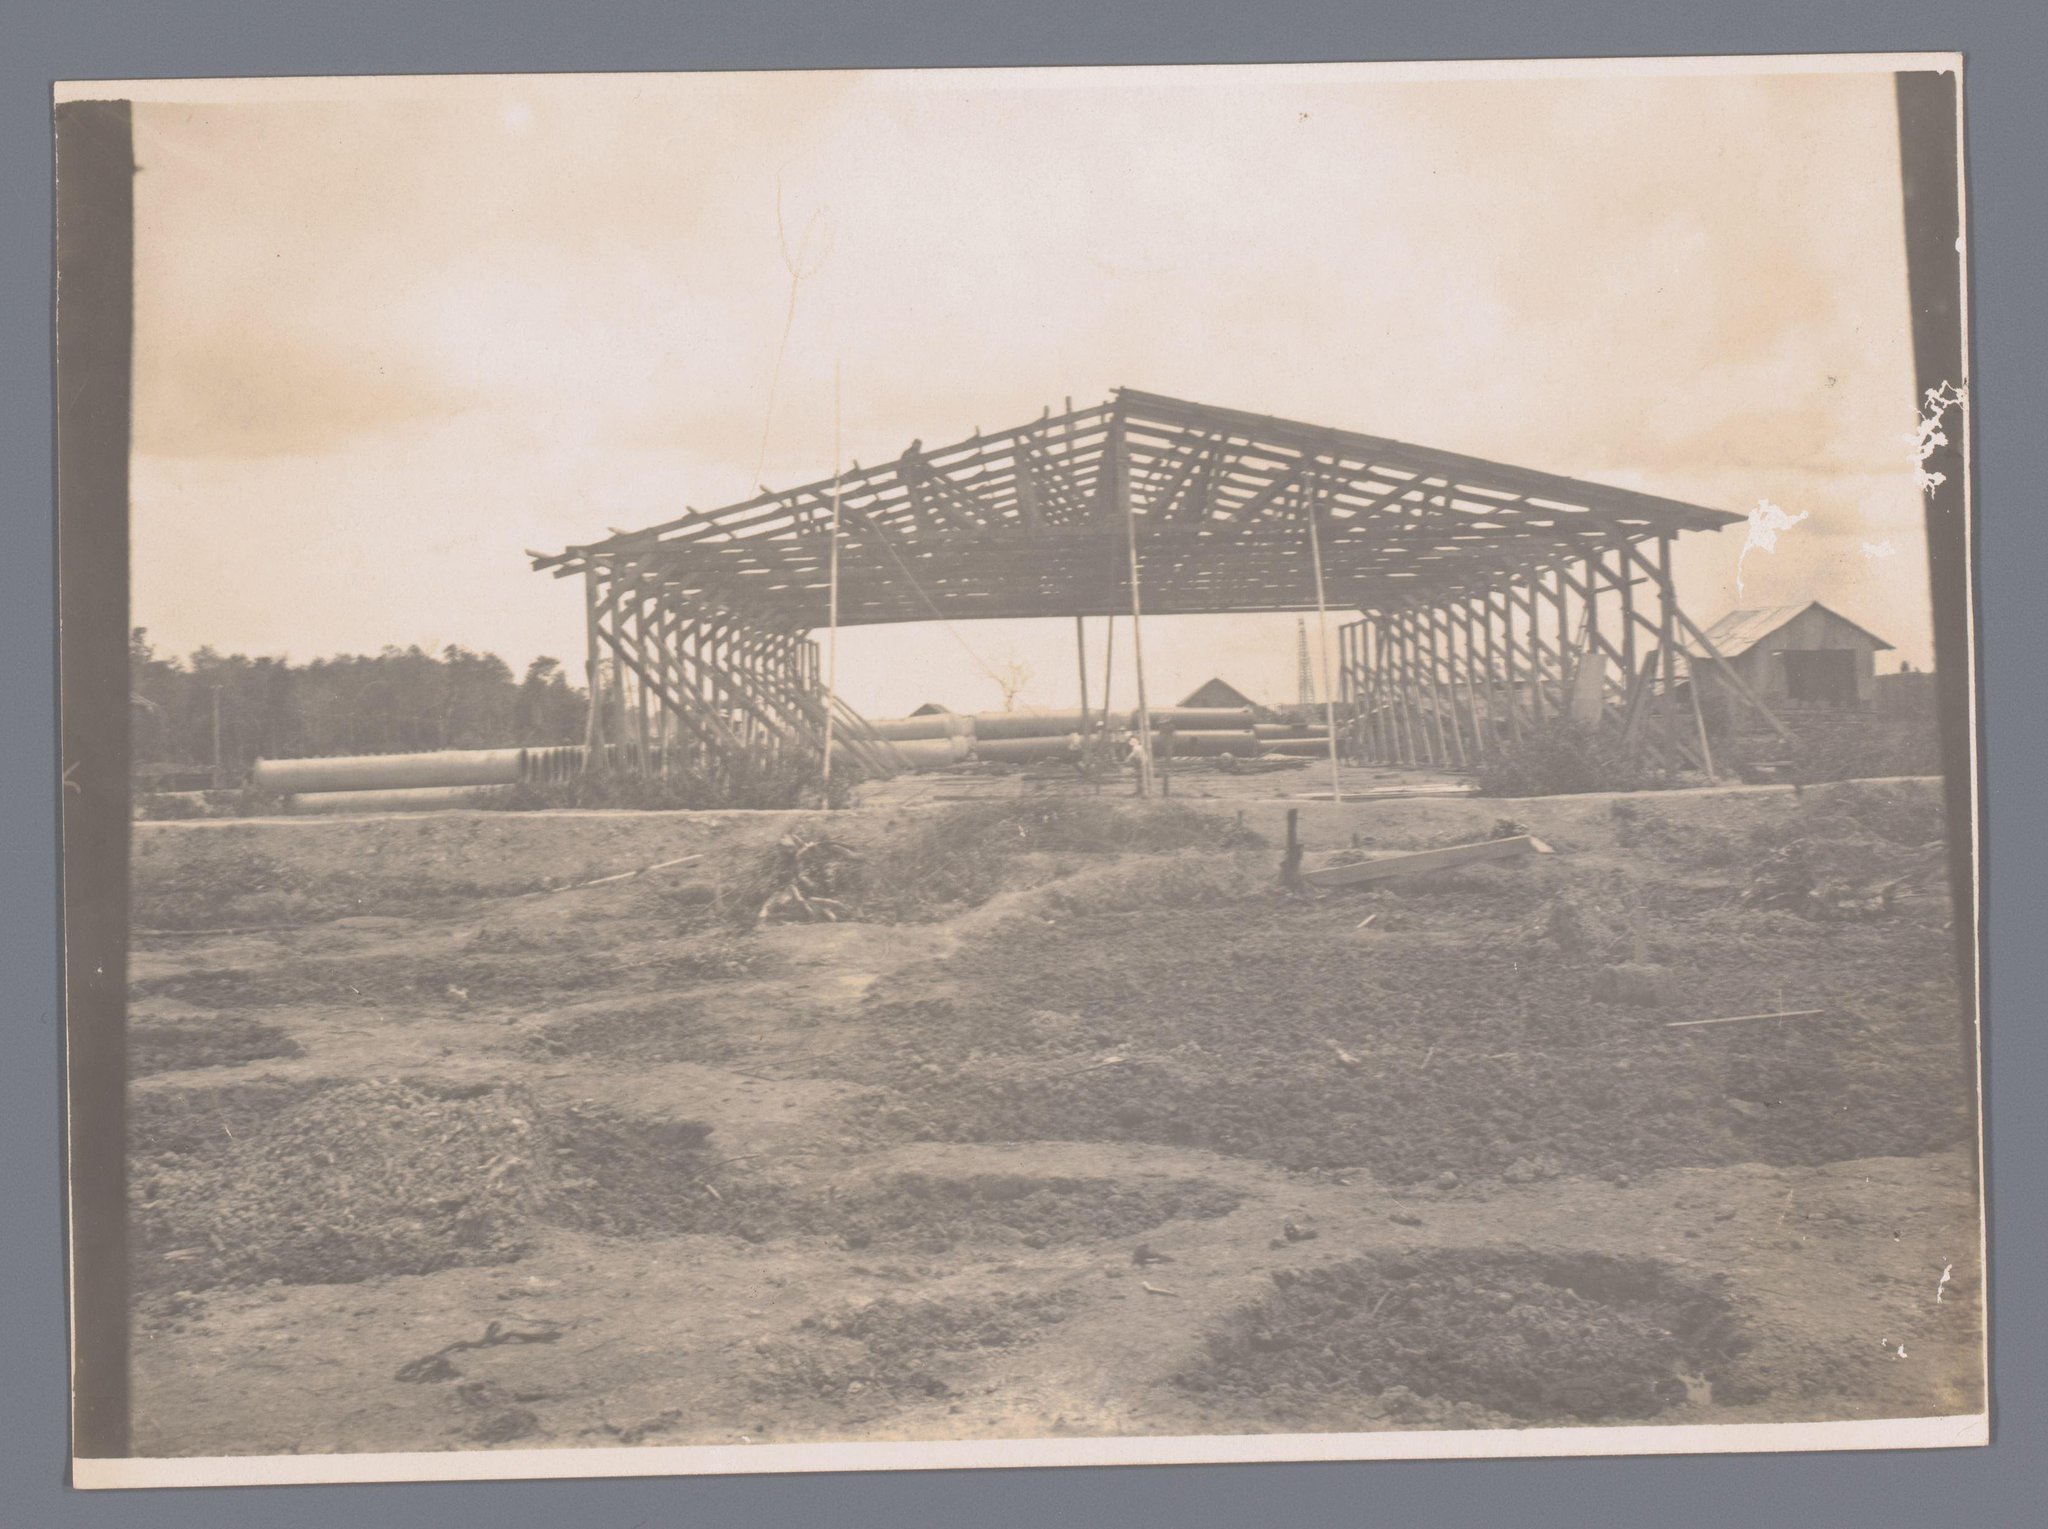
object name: photograph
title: Bouw van een loods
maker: Anonymous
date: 1921-1922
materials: photographic support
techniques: gelatin silver print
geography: belawan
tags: making the overground structures (~ building activities), building-site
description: Geraamte van een loods in aanbouw. Onderdeel van de groep van losse foto's over de aanleg van de haven Belawan aan de kust voor Medan, Sumatra 1921-1922.